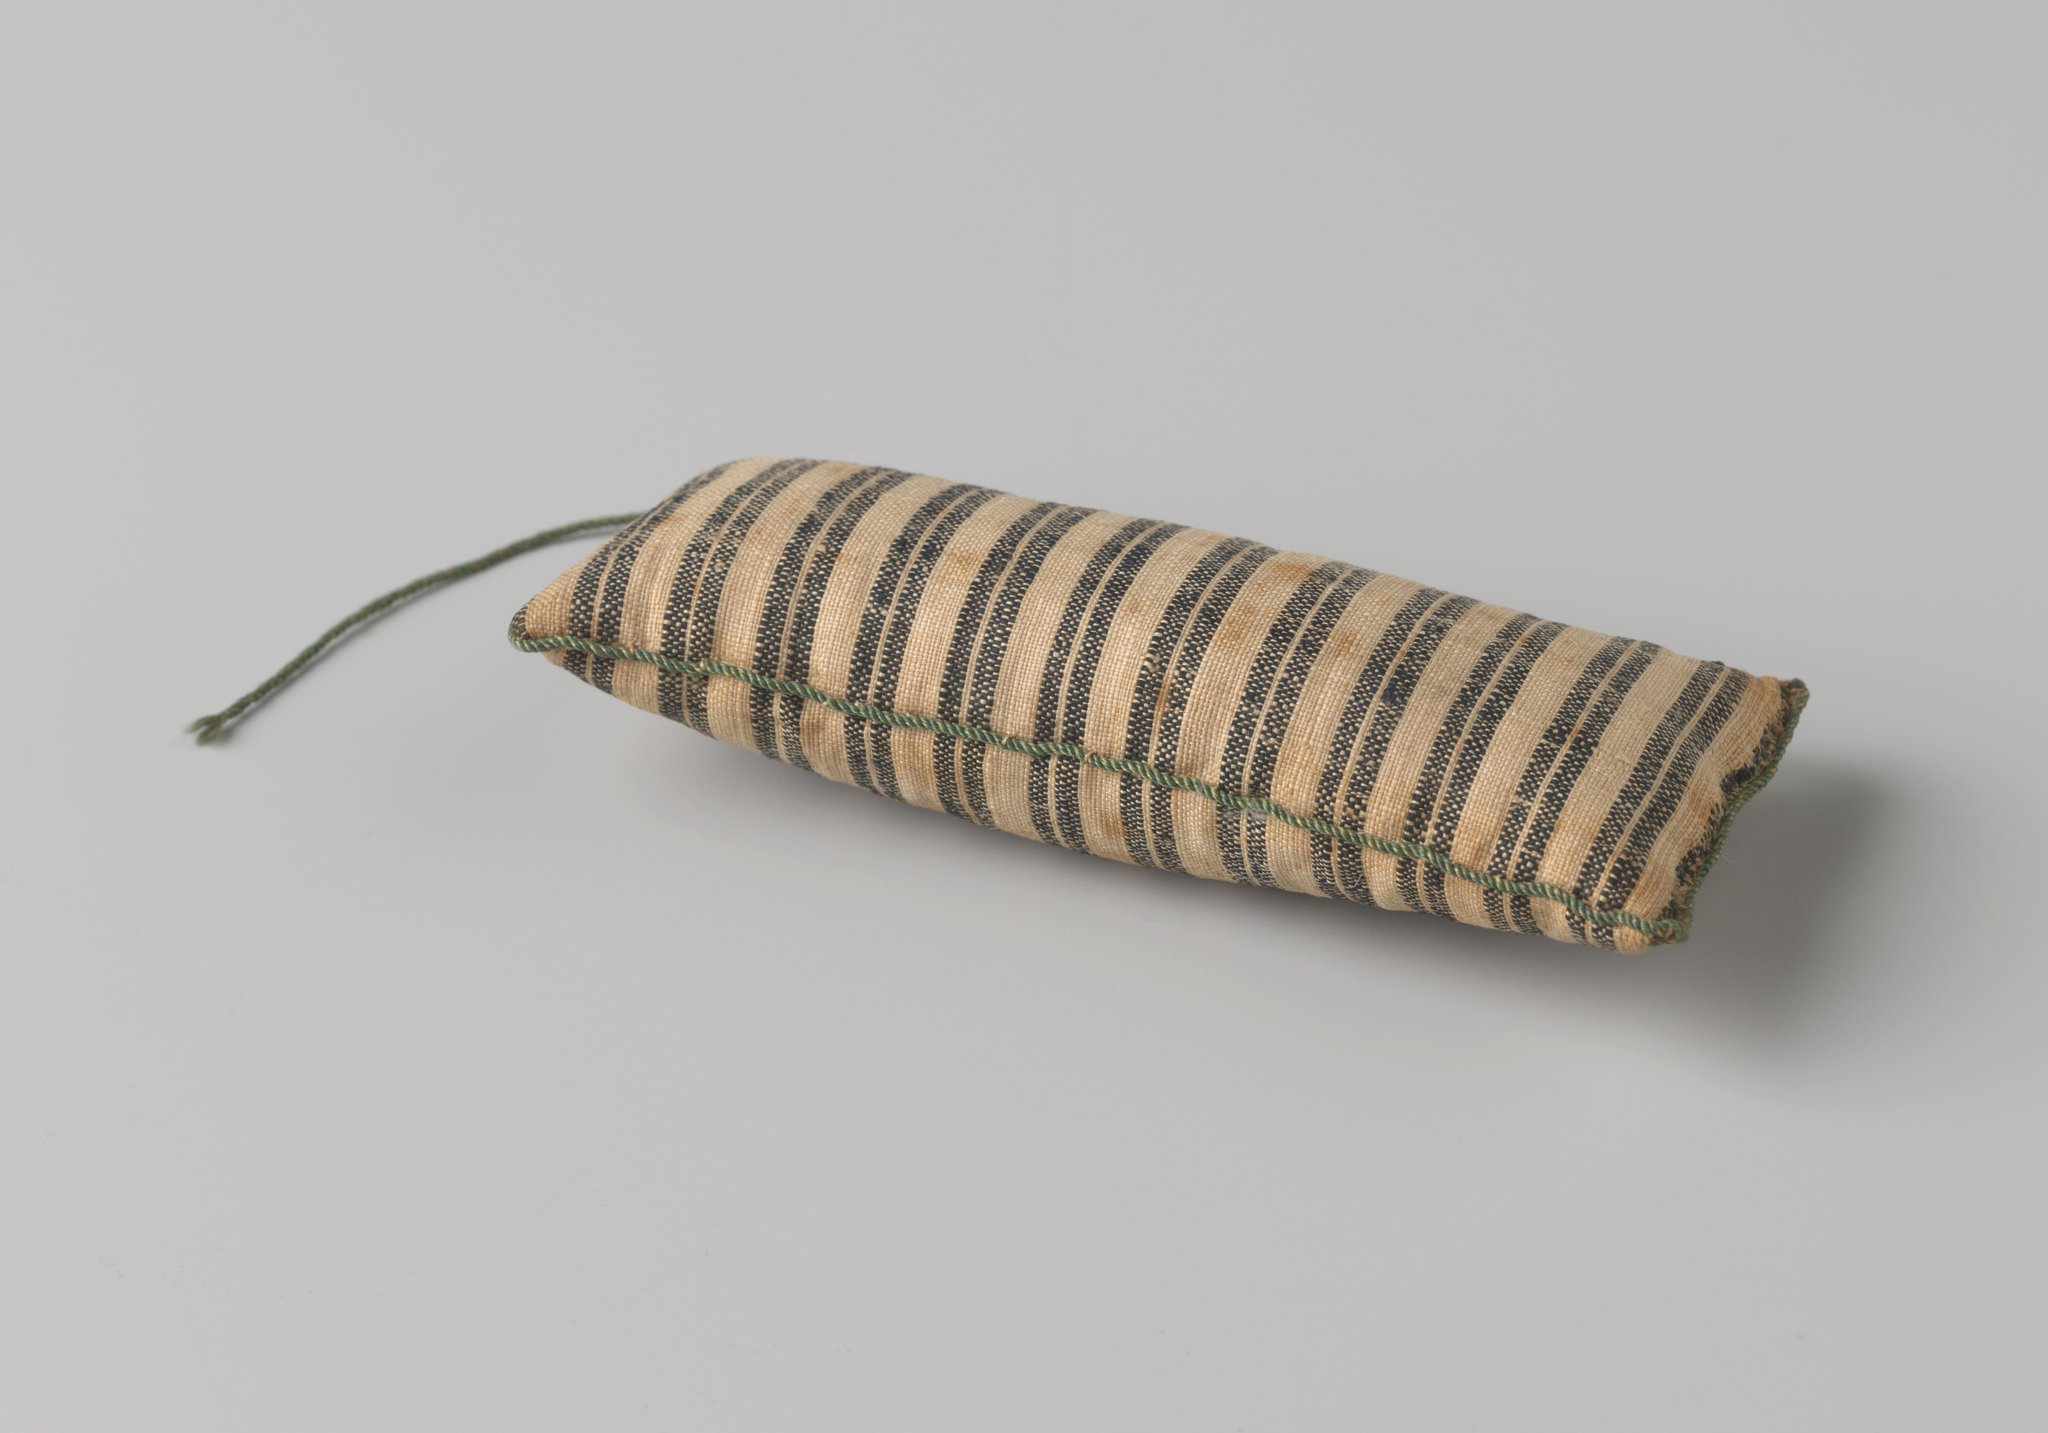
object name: cushion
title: Peluwkussen, blauw-wit gestreept, omzoomd met een groen koord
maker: Anonymous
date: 1750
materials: cotton, down, linen, silk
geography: amsterdam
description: Een peluwkussen van blauw wit gestreepte stof (wit linnen, blauwe katoen) gevuld met dons, omboord met een groen zijden koord uitlopend in een los stuk.